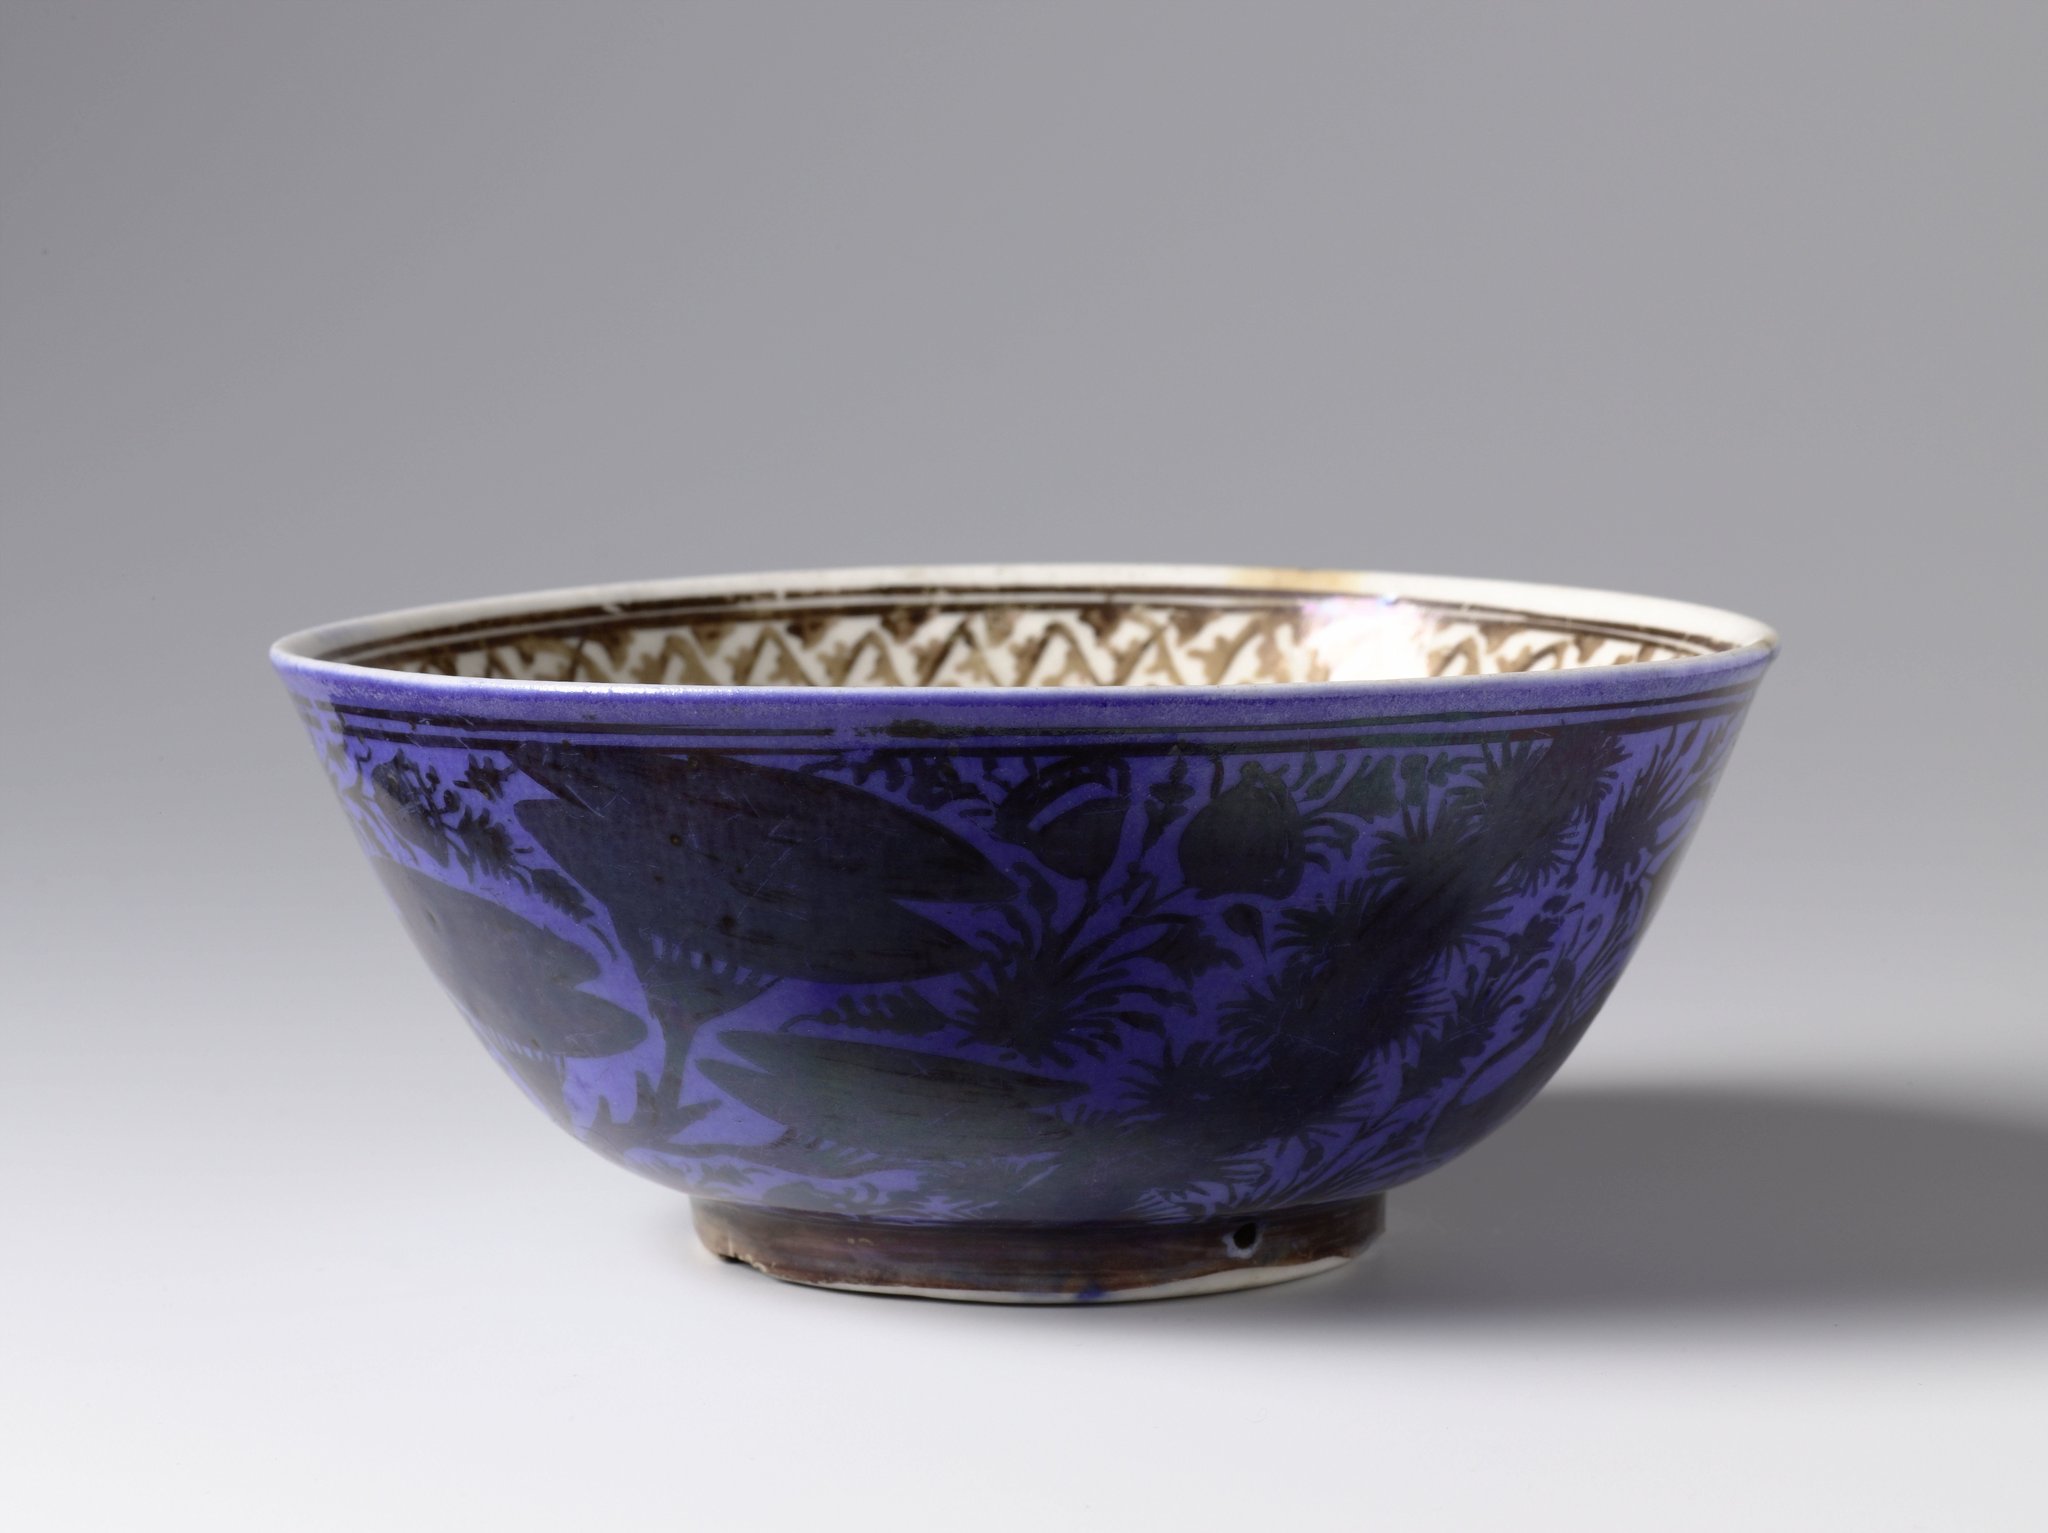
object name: bowl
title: Bowl with flower sprays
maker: Anonymous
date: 1600-1699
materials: earthenware, glaze, luster, paint, quartz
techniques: firing, turning, vitrification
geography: iran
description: Kom van kwarts-fritgoed gedecoreerd met florale motieven in bruin luster op witte en blauwe ondergrond bedekt met transparante glazuur. Op de bodem een rozet van bloemtakken.